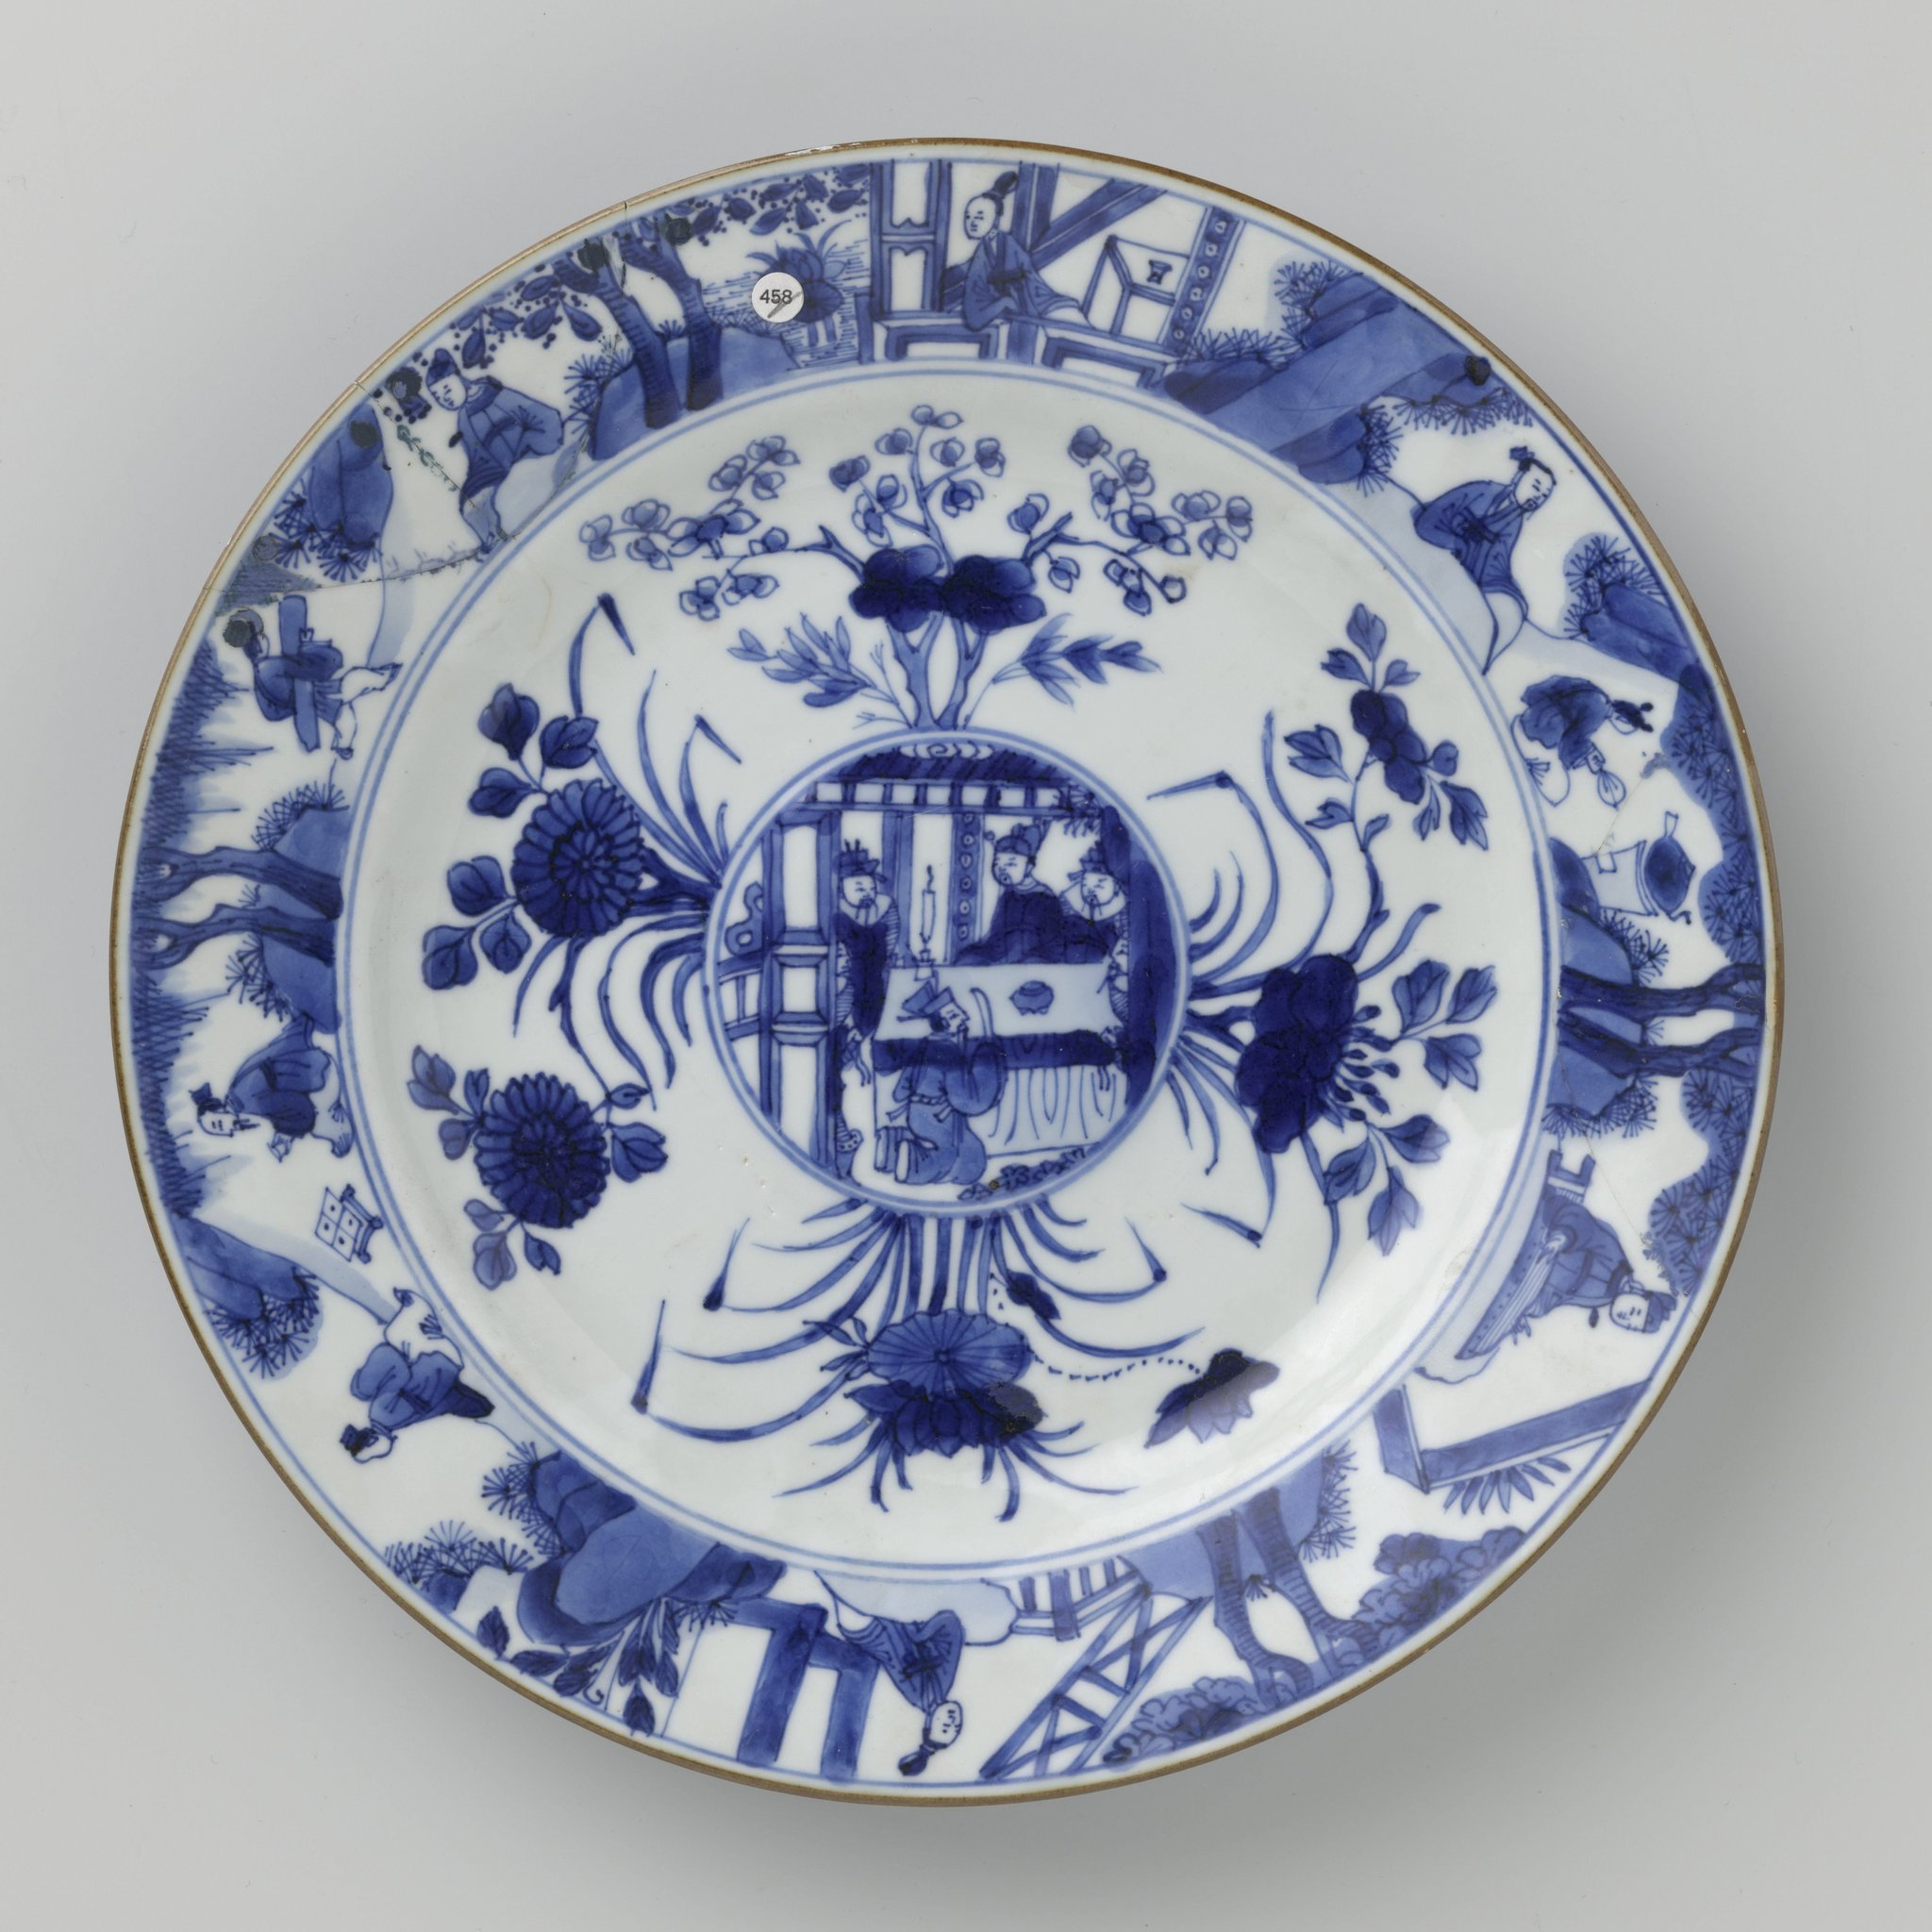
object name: plate dish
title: Plate with flower sprays and figures in an interior and in a landscape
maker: Anonymous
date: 1700-1724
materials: cobalt, glaze, paint, porcelain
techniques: firing, turning, vitrification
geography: china